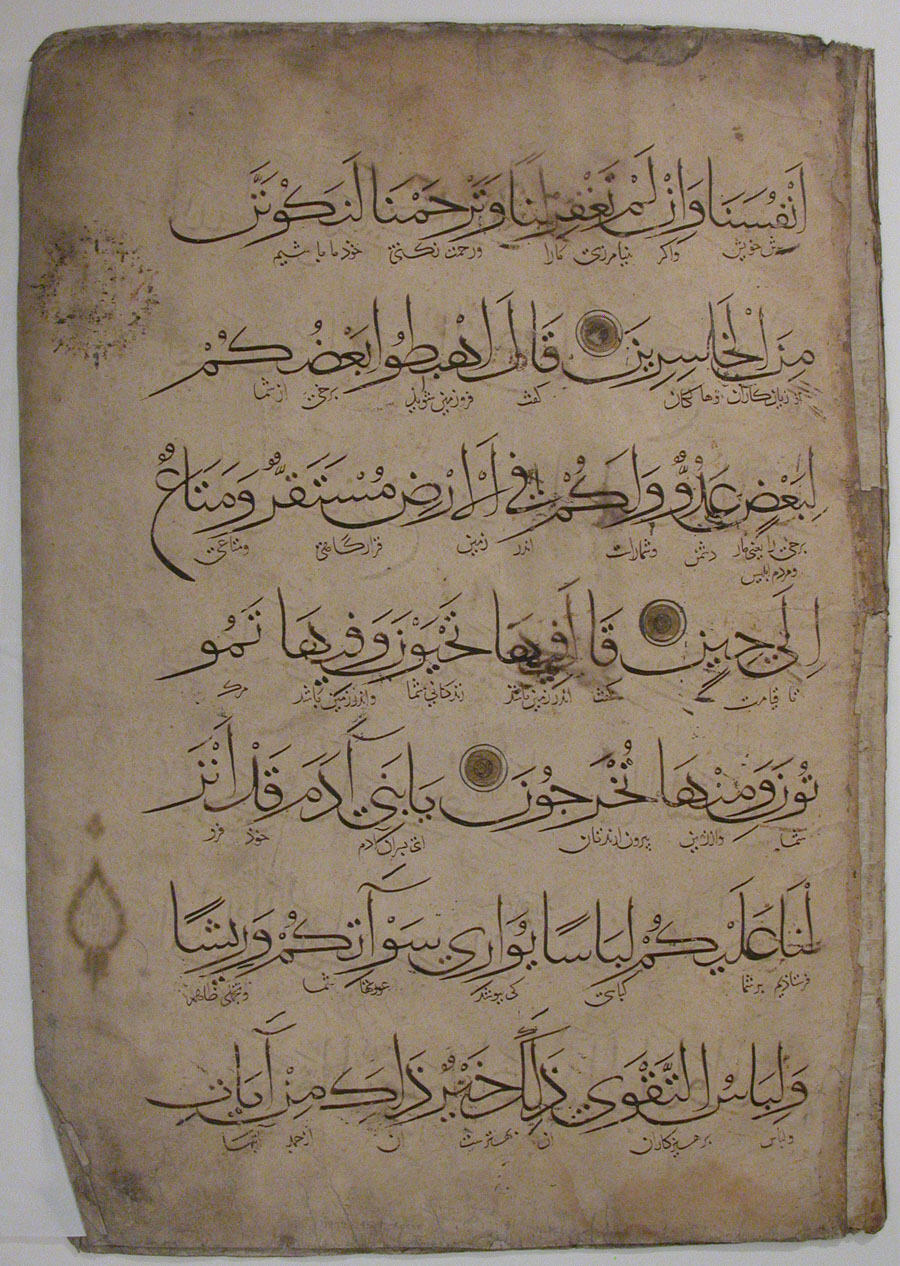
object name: folio from a non illustrated manuscript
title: Folio from a Qur'an Manuscript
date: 1301-1400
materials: gold, ink, paper, watercolor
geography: india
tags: qur'an,calligraphy